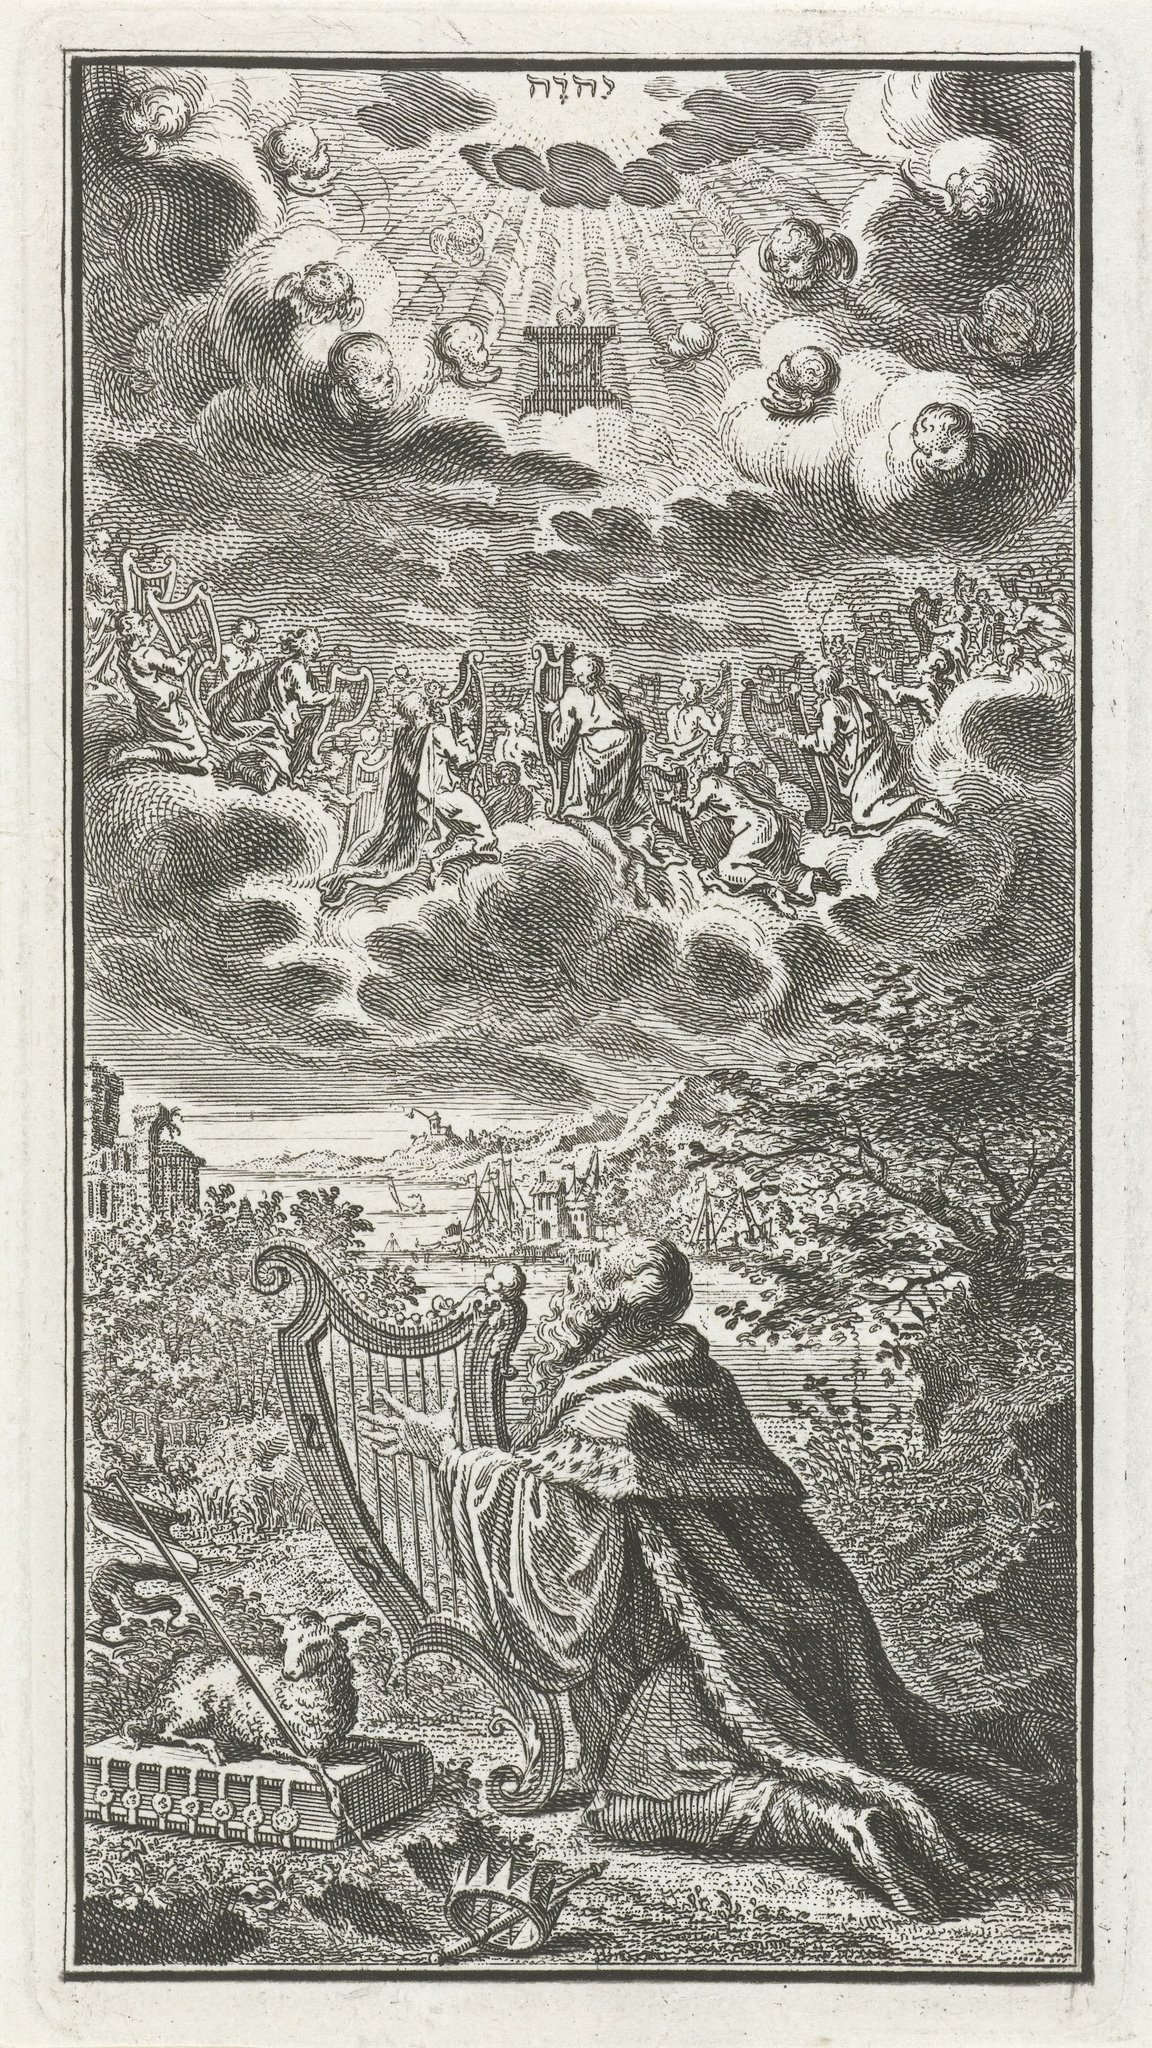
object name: print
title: David bespeelt de harp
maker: simon fokke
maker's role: draughtsman, print maker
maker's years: 1712-1784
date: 1722-1784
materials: paper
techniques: etching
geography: amsterdam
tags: david as musician, usually playing the harp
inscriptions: collector's mark: Lugt 2228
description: David speelt op zijn harp en kijkt hierbij naar de hemel die gevuld is met eveneens harp spelende engelen en putti. Geheel bovenin staat onder het tetragram een brandend hart op een altaar, het symbool van liefde.